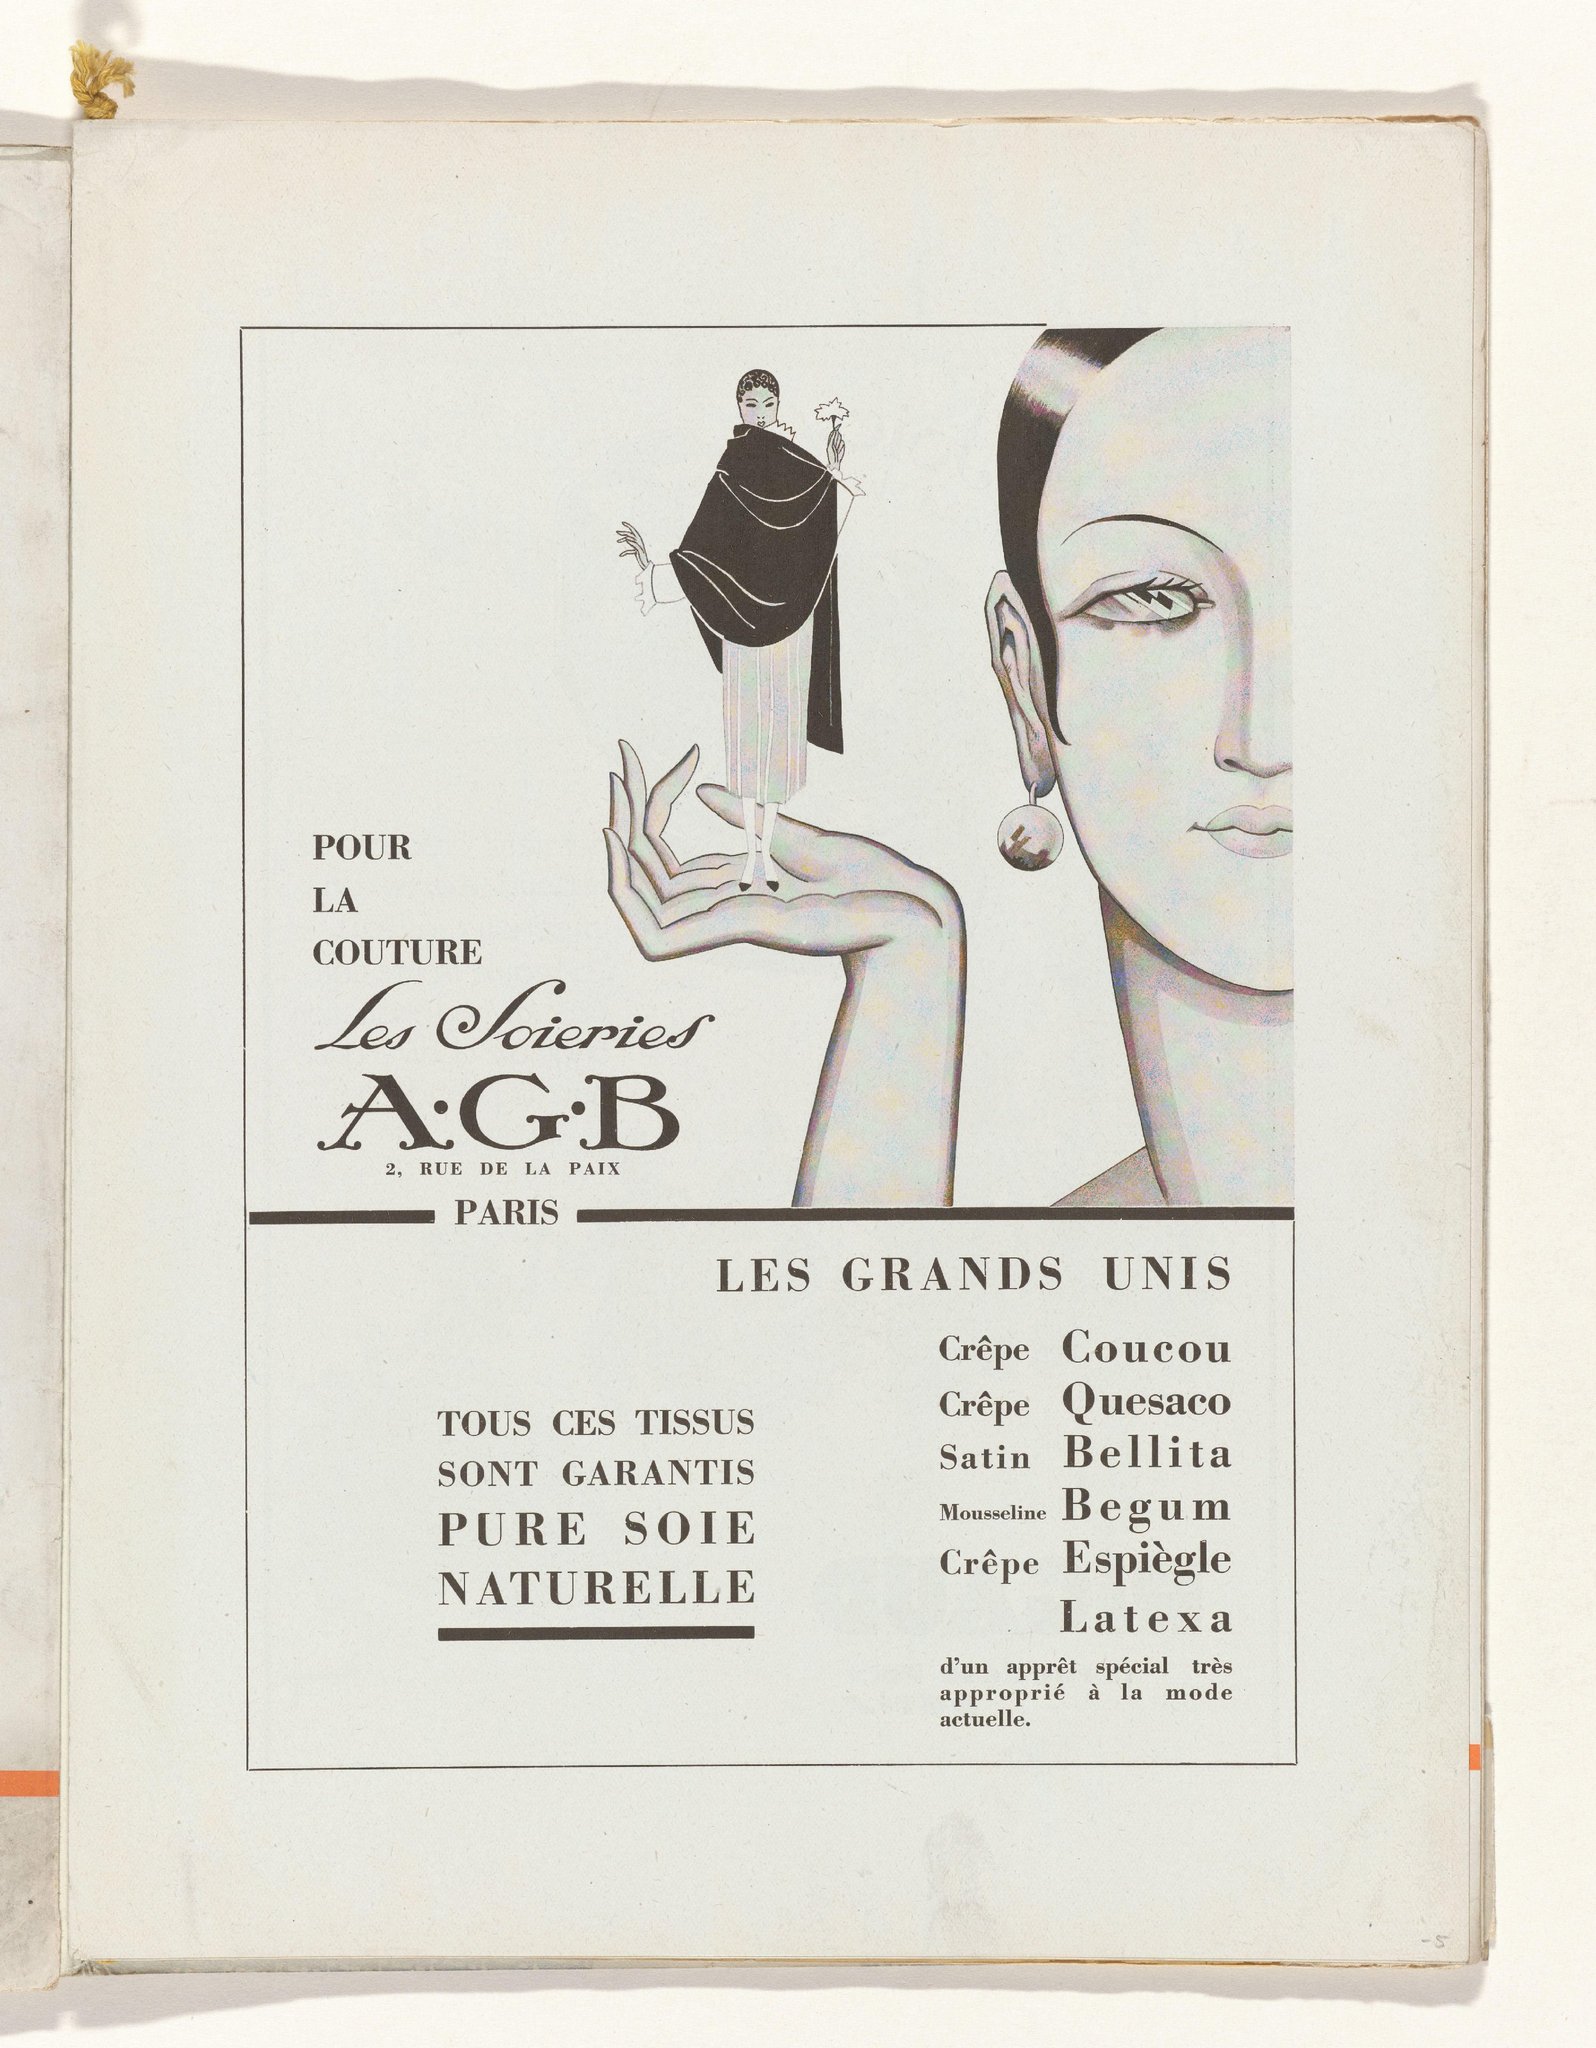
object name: magazine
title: Art - Goût - Beauté, Feuillets de l' élégance féminine, Mai 1931, No. 129, 11e Année, p. 5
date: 1931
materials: paper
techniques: photography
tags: ear-rings (+ women's clothes), neck-gear ~ clothing (shawl) (+ women's clothes), fashion plates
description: Advertentie voor stoffen: 'Les Soieries A.G.B.'.Pagina uit het modetijdschrift Art-Goût-Beauté (1920-1933).